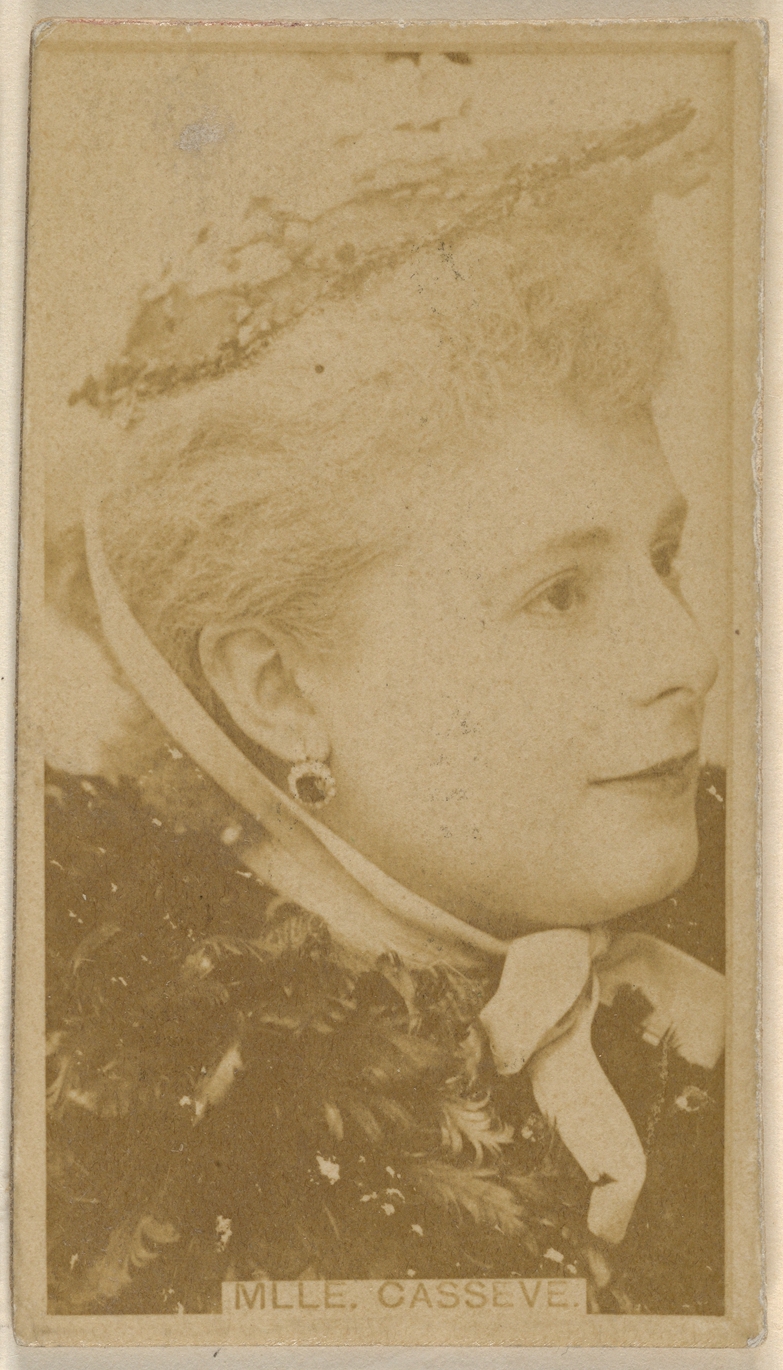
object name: photograph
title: Mlle. Casseve, from the Actors and Actresses series (N45, Type 8) for Virginia Brights Cigarettes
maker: allen & ginter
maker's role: publisher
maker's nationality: american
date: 1888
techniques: albumen silver print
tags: portraits,women,actresses